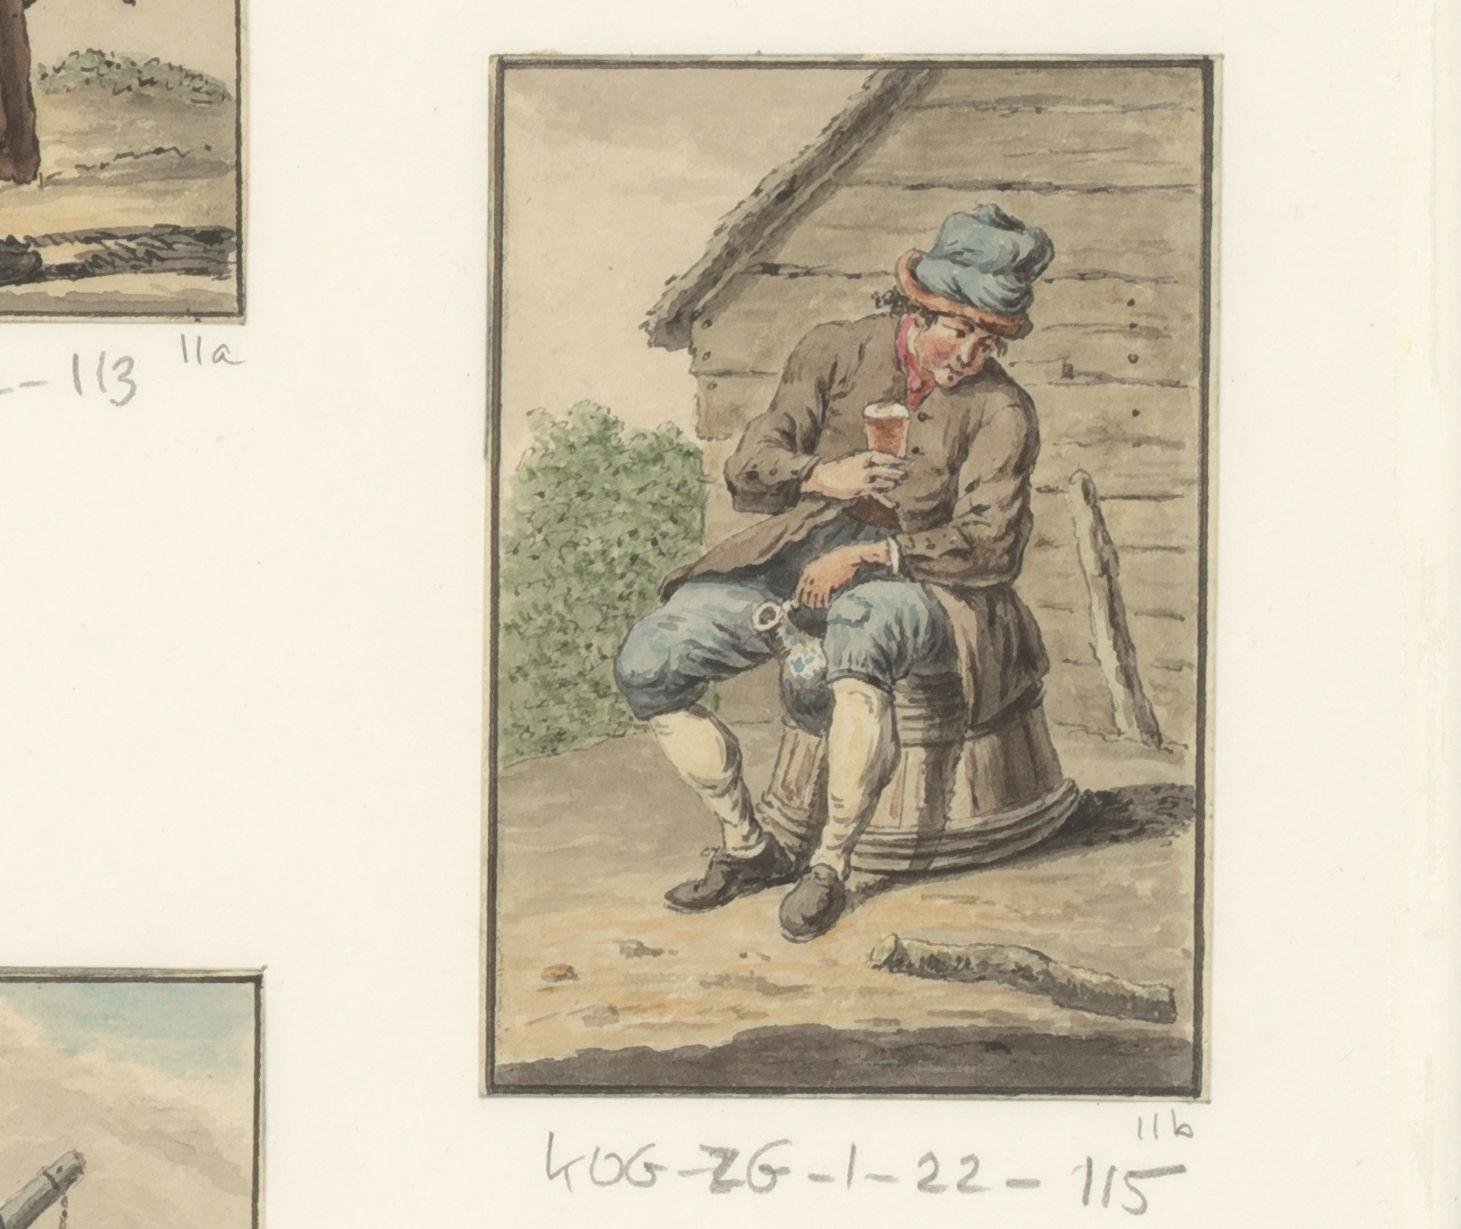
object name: drawing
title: Drinkende boer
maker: Anonymous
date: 1800-1875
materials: paper, watercolor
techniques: brush, pen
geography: netherlands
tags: farmers, clothes, costume (+ men's clothes), pavement, terrace in front of inn or restaurant, folk costume, regional costume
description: Drinkende boer. Kopie naar een prent in de serie getiteld '8 beeldjes'. Onderwerpsrubrieken binnen de Atlas Zeden en Gewoonten: De Kleeding, Volkskleederdracht, Noord-Holland.